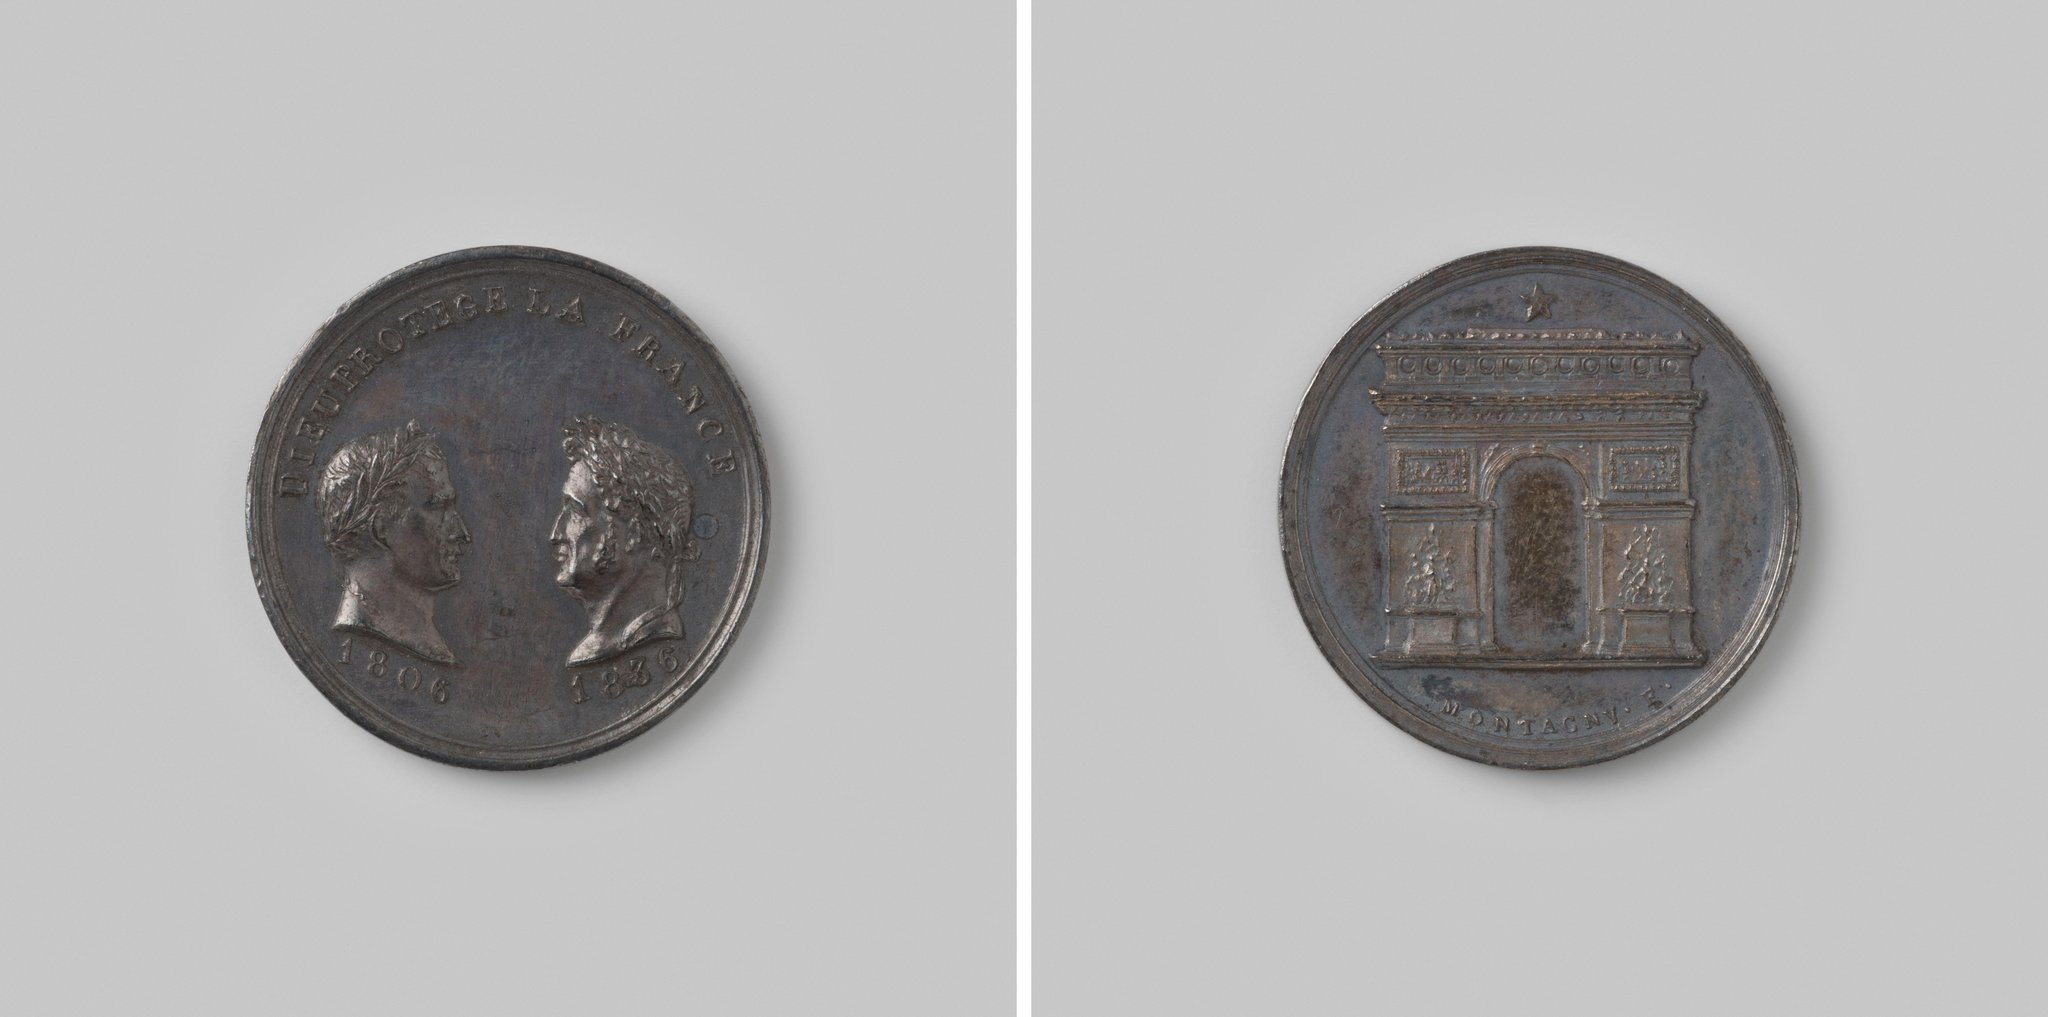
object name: history medal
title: Inwijding van de Arc de Triomphe te Parijs 1836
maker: montagny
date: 1836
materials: silver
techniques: striking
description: Zilveren penning, op de voorzijde de elkaar toegewende portretten van Napoleon en Louis-Phillipe elk boven een jaartal, met omschrift, op de keerzijde Arc de Triomphe waarboven een ster.